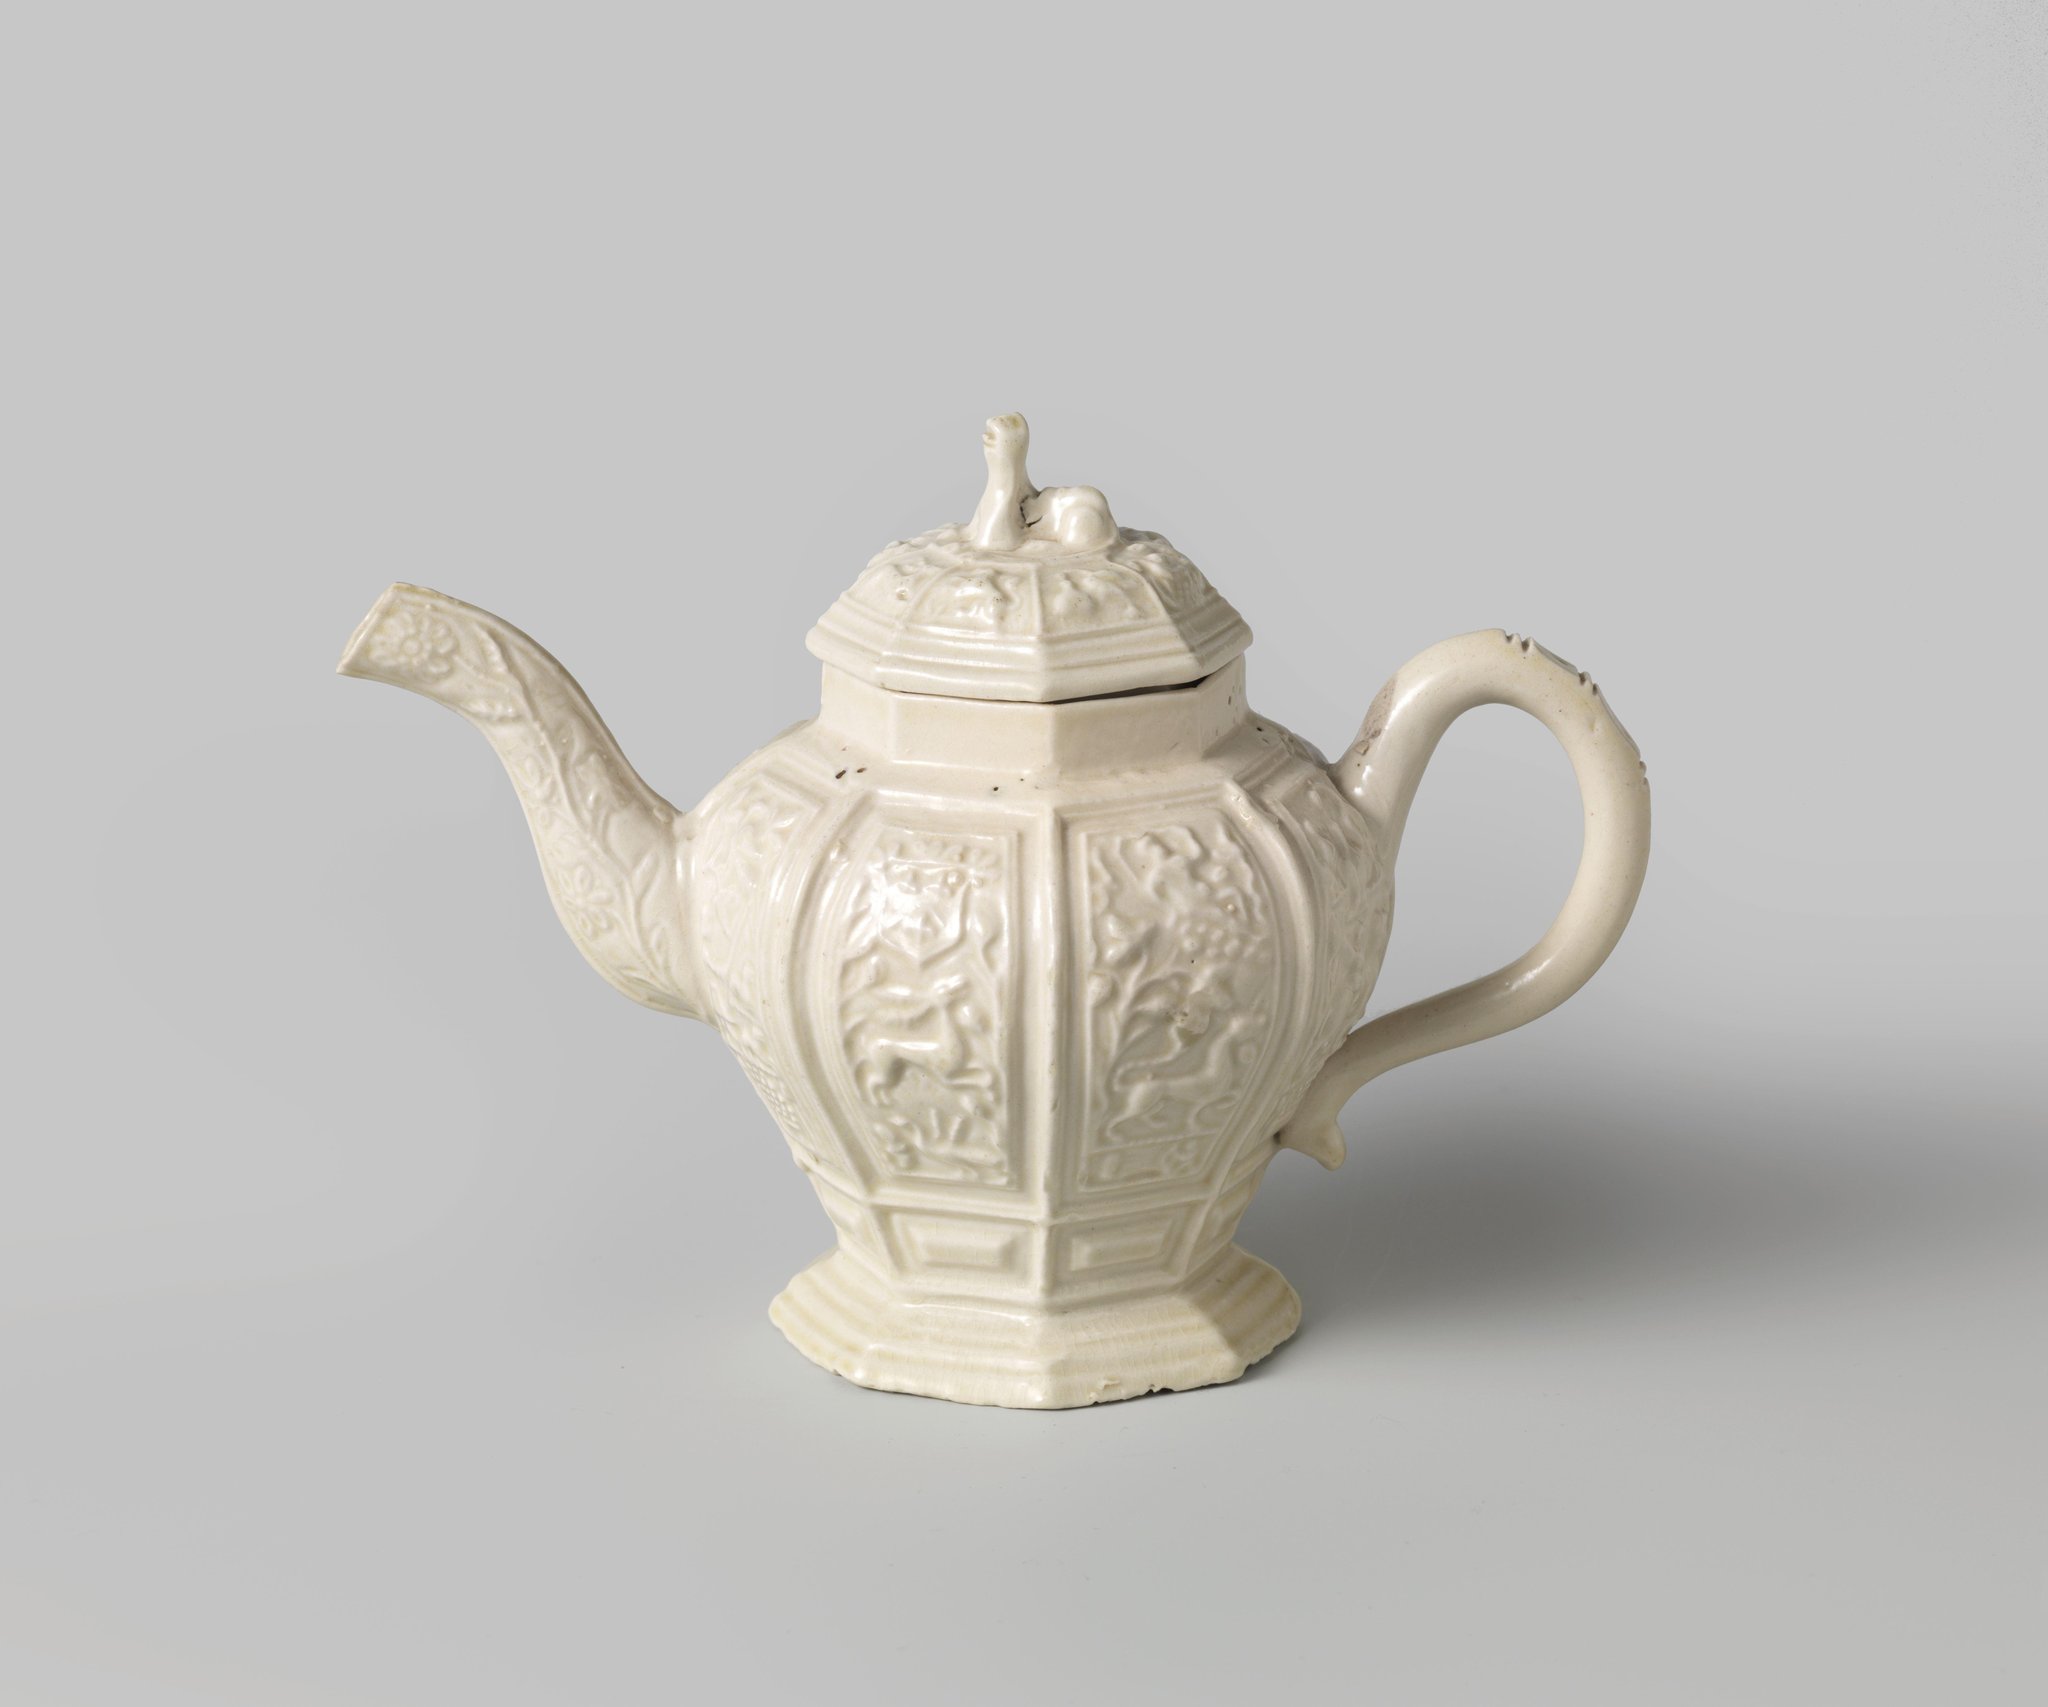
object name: pot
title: Theepot met deksel van steengoed met zoutglazuur; Staffordshire.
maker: Anonymous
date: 1740-1760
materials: stoneware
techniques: salt glaze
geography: england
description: Theepot van steengoed met zoutglazuur. De theepot is achthoekig en heeft op de acht zijden reliëfversieringen, bestaande uit bomen, figuren, dieren en een wapen. Het deksel heeft een leeuw of hond als knop. De tuit heeft aan beide zijden een bloemtak.